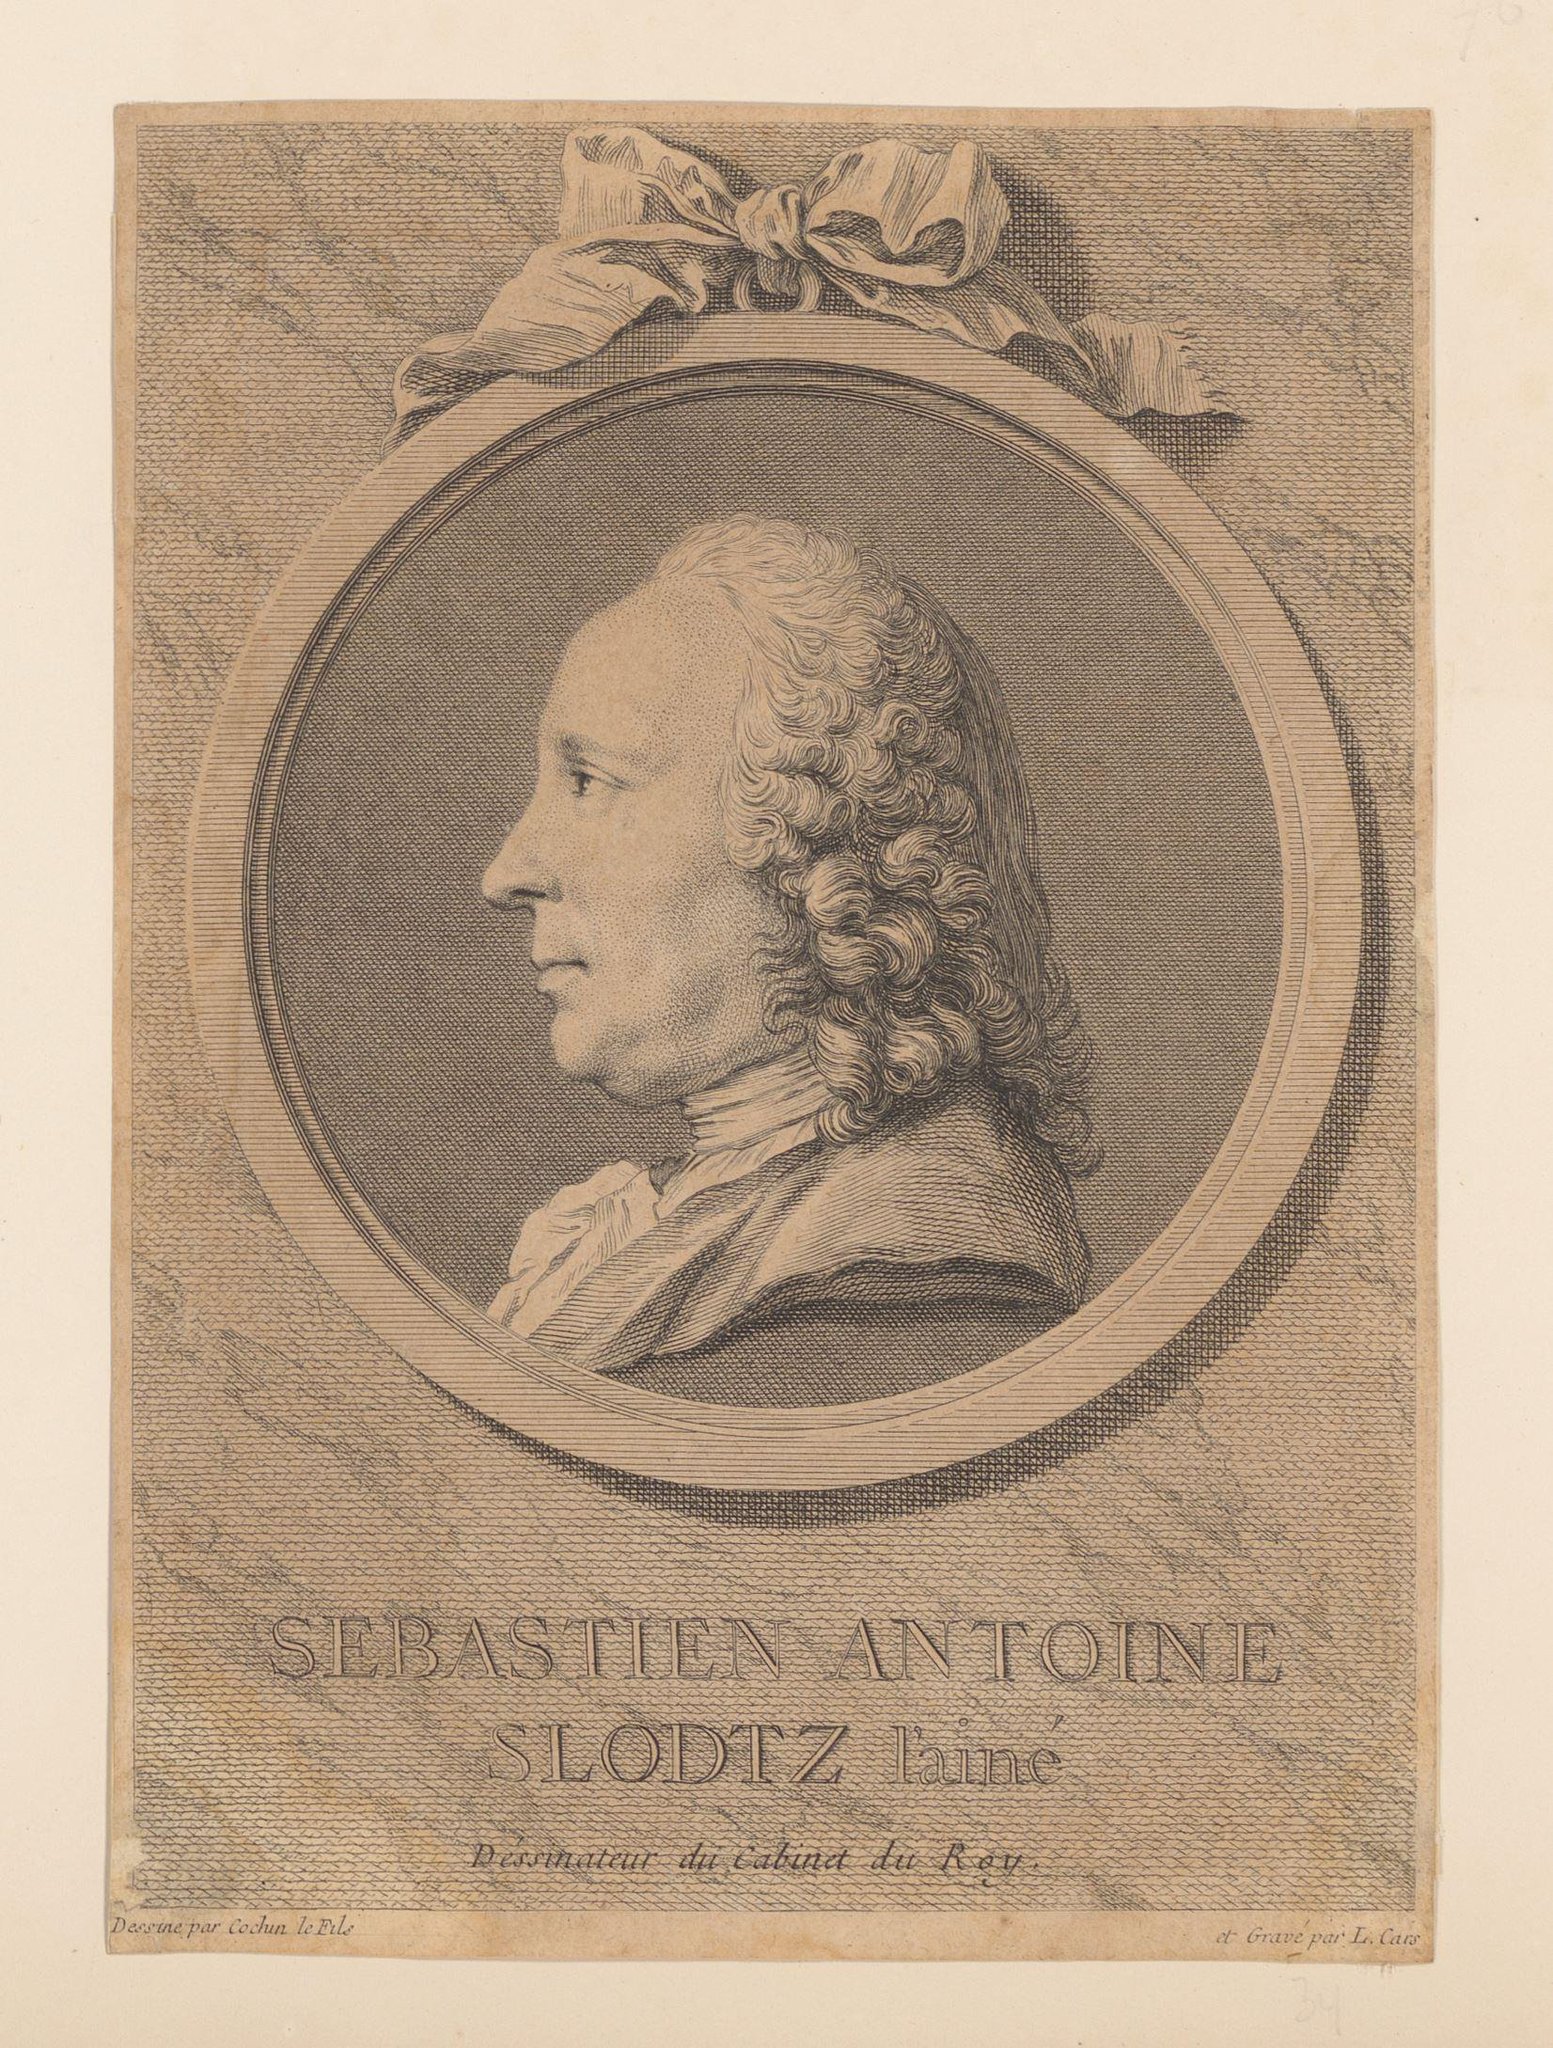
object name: print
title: Sebastien Antoine Slodtz l'ainé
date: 1757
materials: paper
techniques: engraving, etching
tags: sculptor, sébastien antoine slodtz, historical persons, portrait, self-portrait of graphic artist